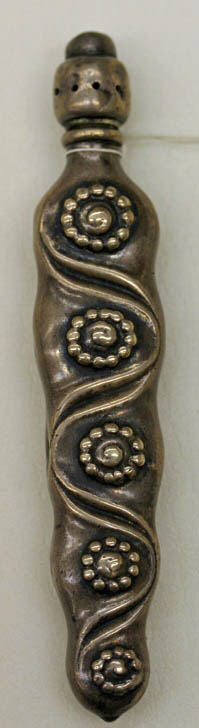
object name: accessory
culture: american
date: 1873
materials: silver